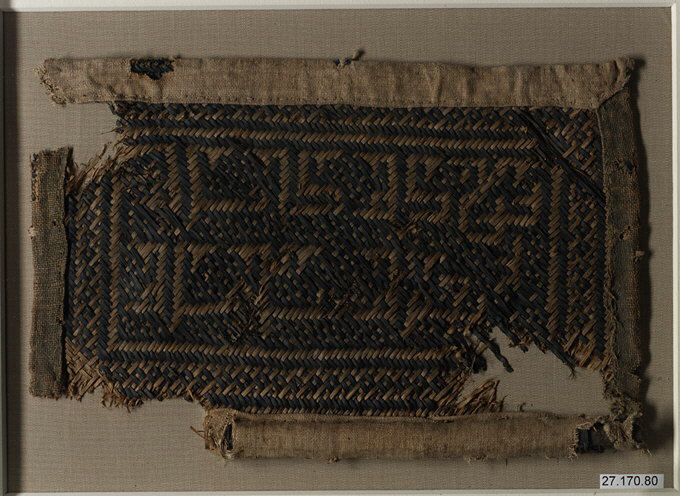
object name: fan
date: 901-1300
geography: egypt or syria